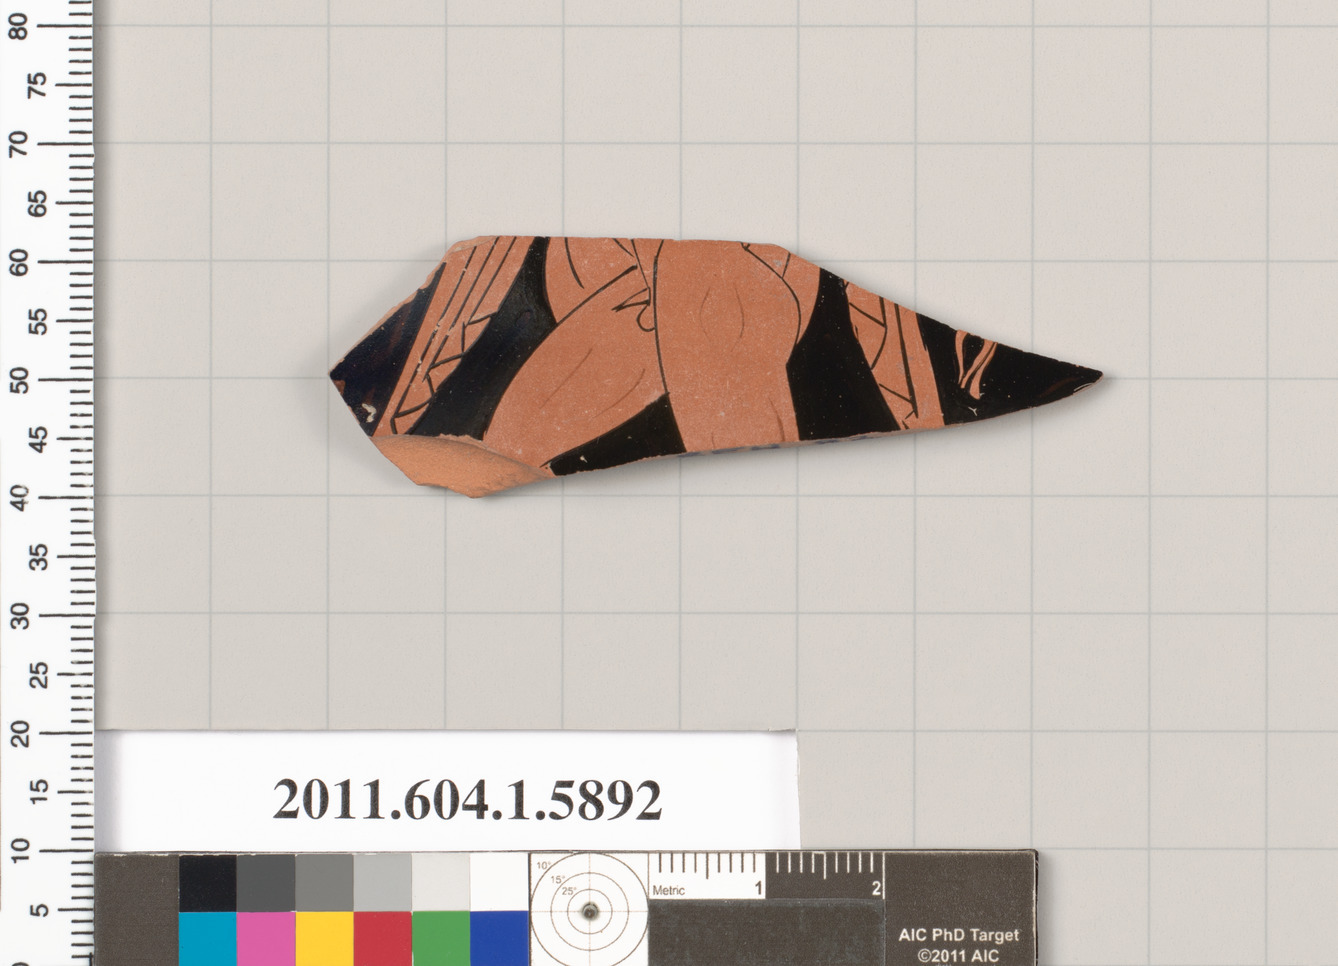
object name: kylix fragment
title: Terracotta fragment of a kylix (drinking cup)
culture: greek, attic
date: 520-510 BCE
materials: terracotta